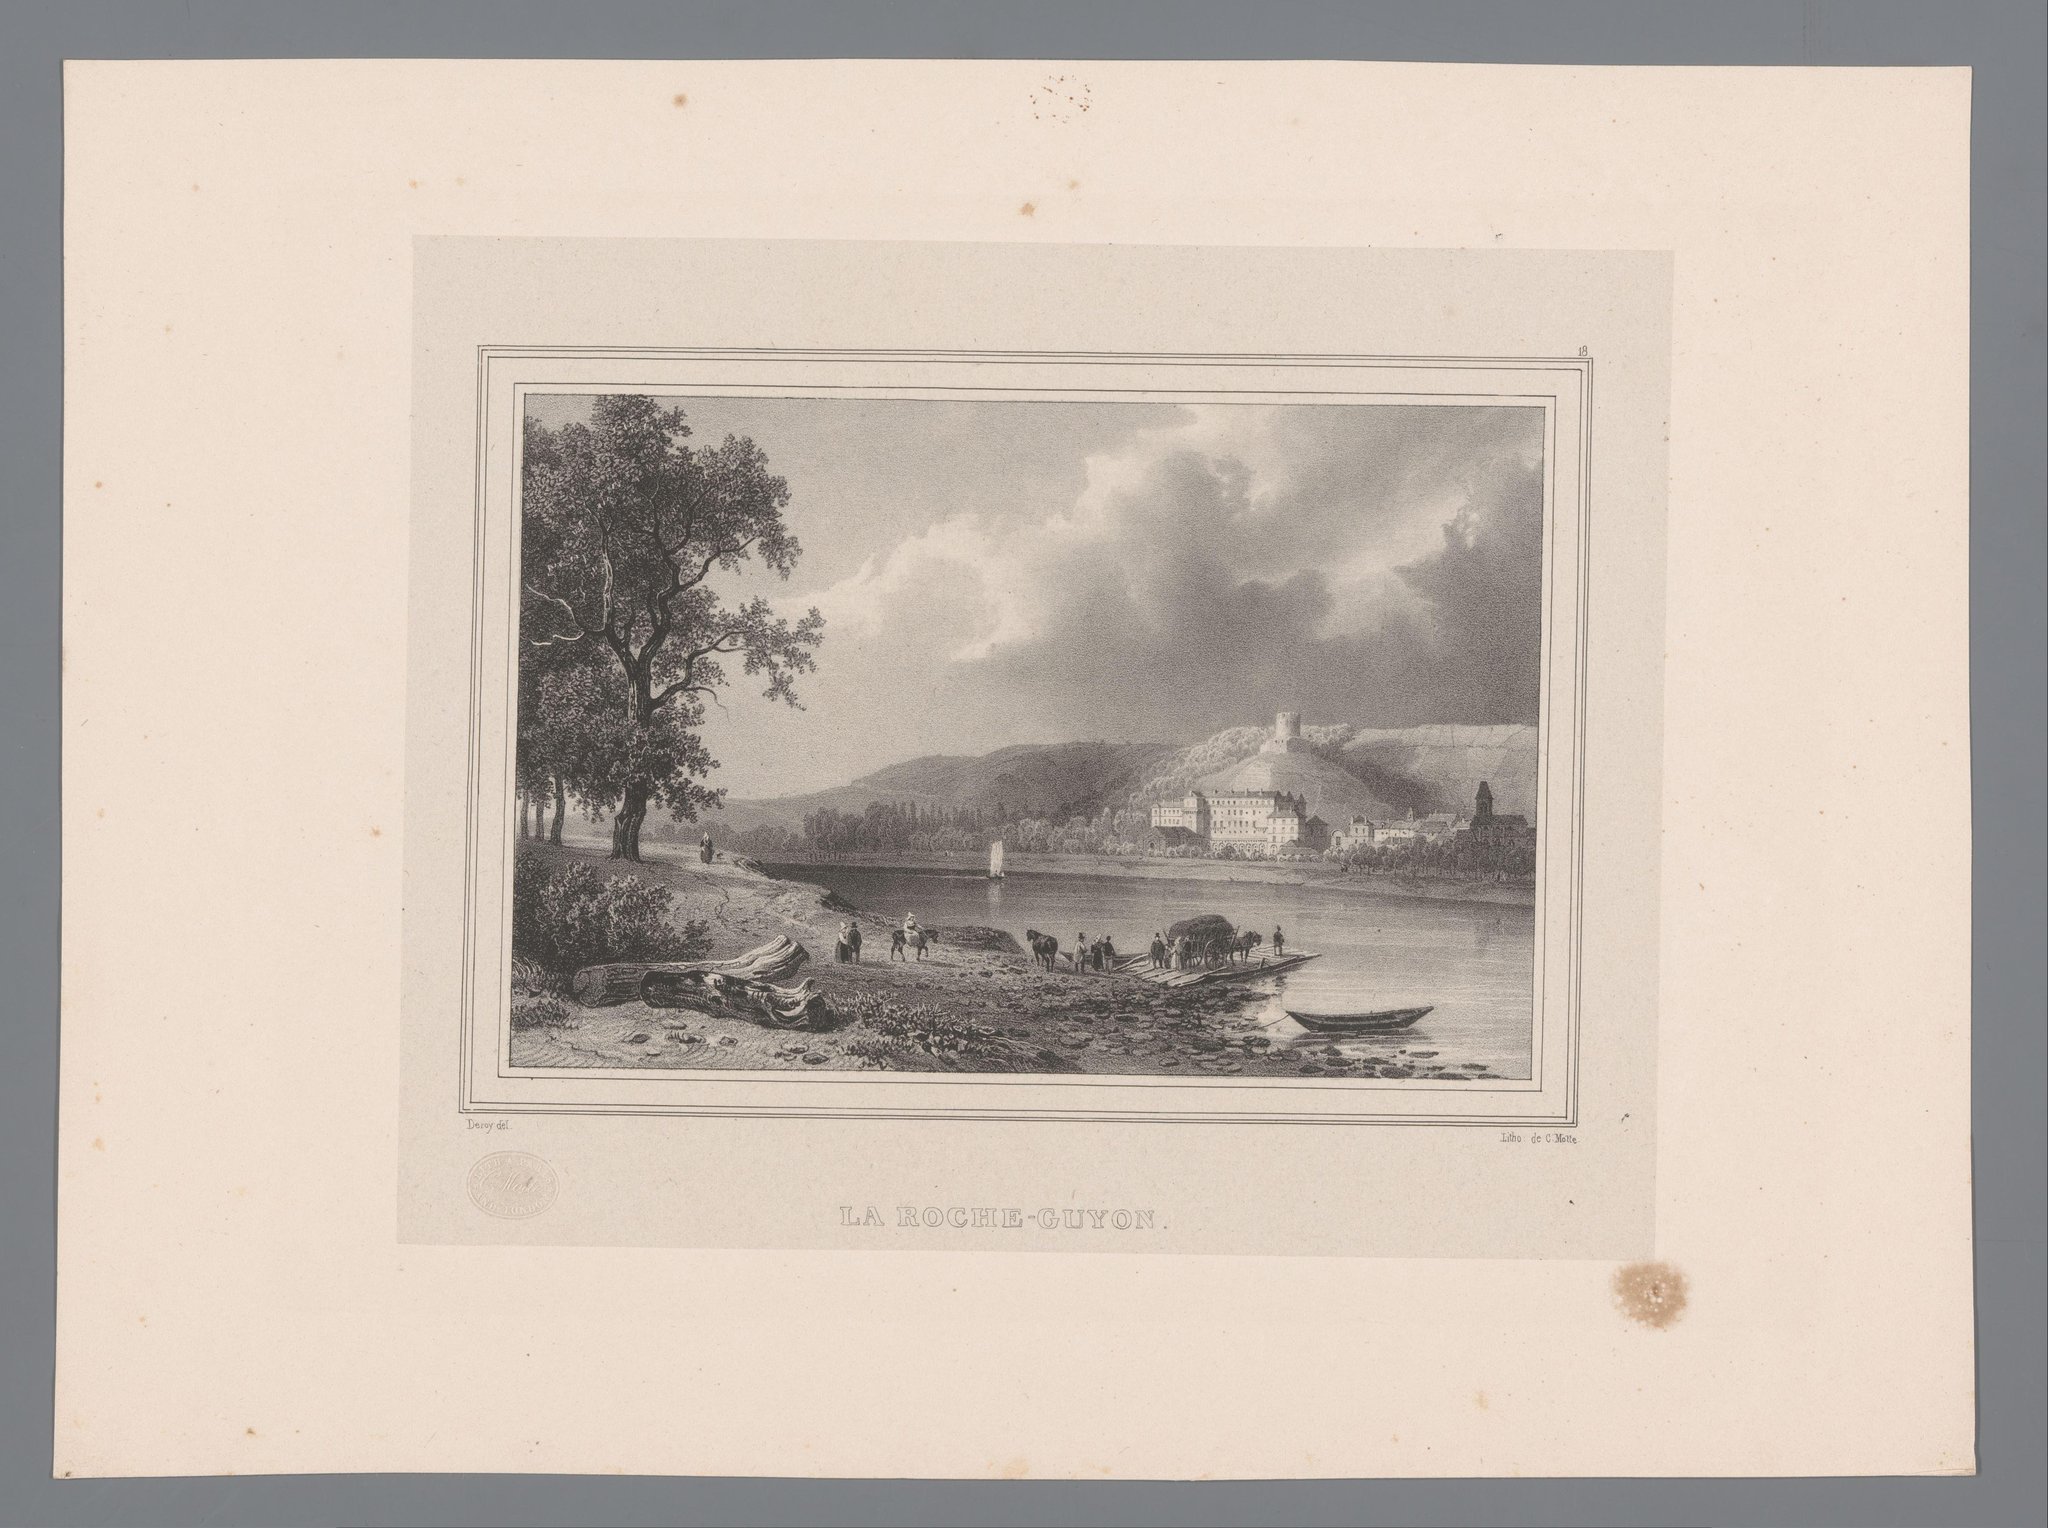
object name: print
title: La Roche-Guyon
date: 1829-1831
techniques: printmaking, lithograph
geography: paris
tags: quay (+ city(-scape) with figures, staffage), river (+ landscape with figures, staffage), prospect of city, town panorama, silhouette of city (+ city(-scape) with figures, staffage)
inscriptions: check stamp: Lugt 1828b, collector's mark: Lugt 2228a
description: Prent maakt deel uit van een omslag met twaalf prenten.